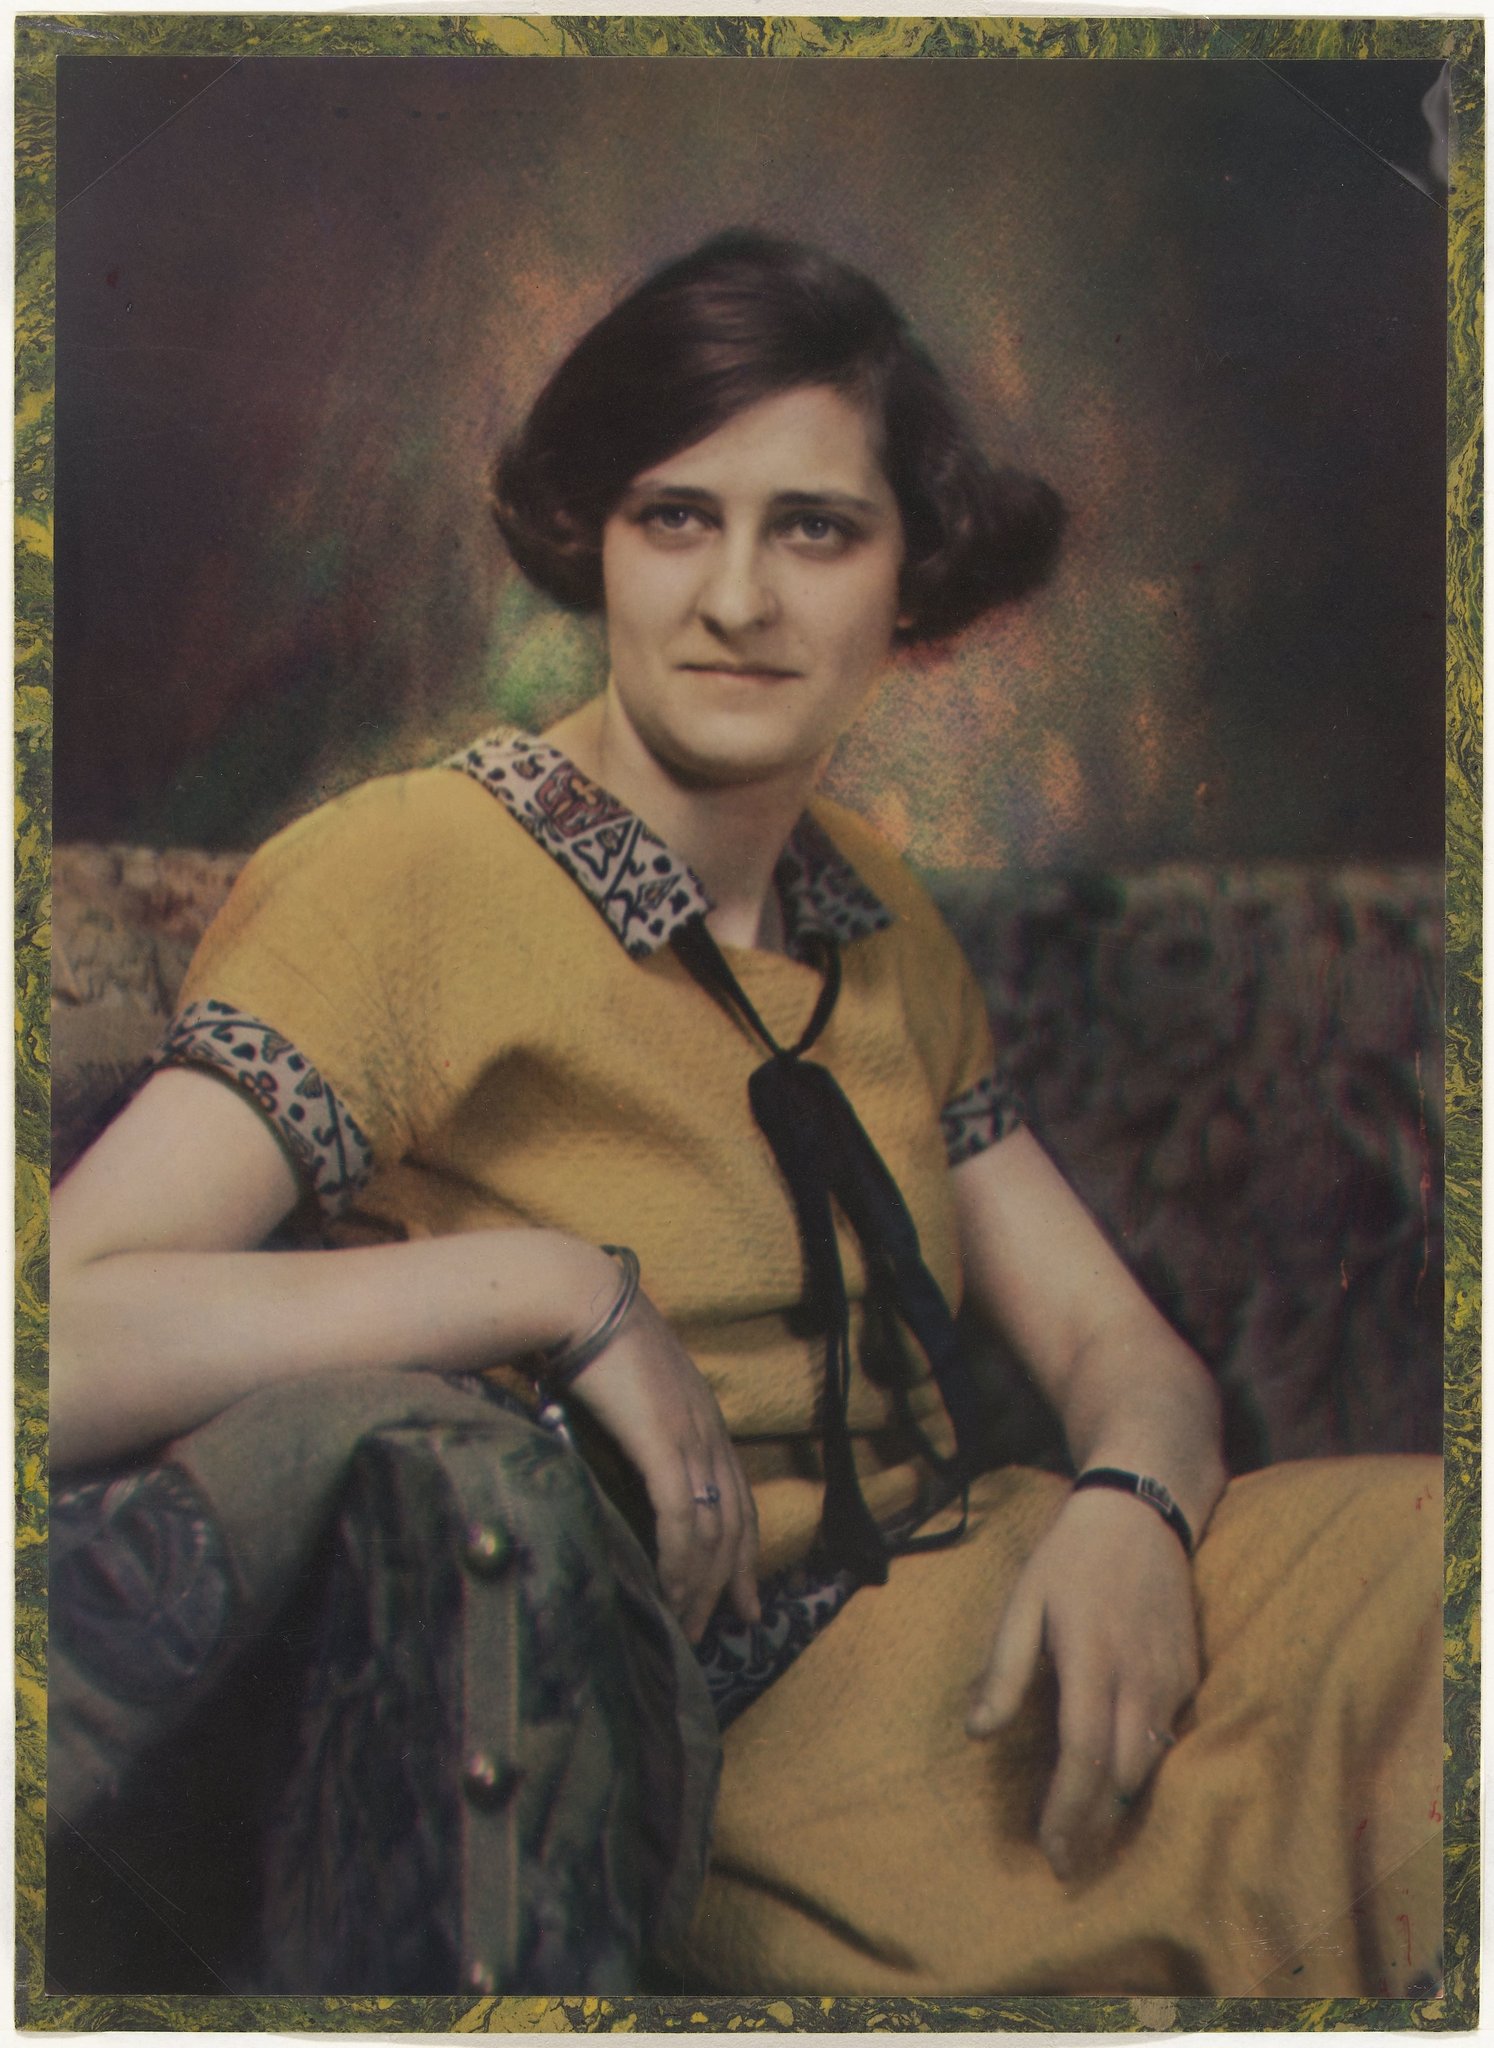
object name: photograph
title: Portret van Mies Rosenboom - Merkelbach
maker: jacob merkelbach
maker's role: fotograaf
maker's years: 1877-1942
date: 1920-1930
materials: cardboard, photographic support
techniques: jos-pé print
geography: amsterdam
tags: amsterdam, mies rosenboom-merkelbach, historical persons (portraits and scenes from the life) - bb - woman